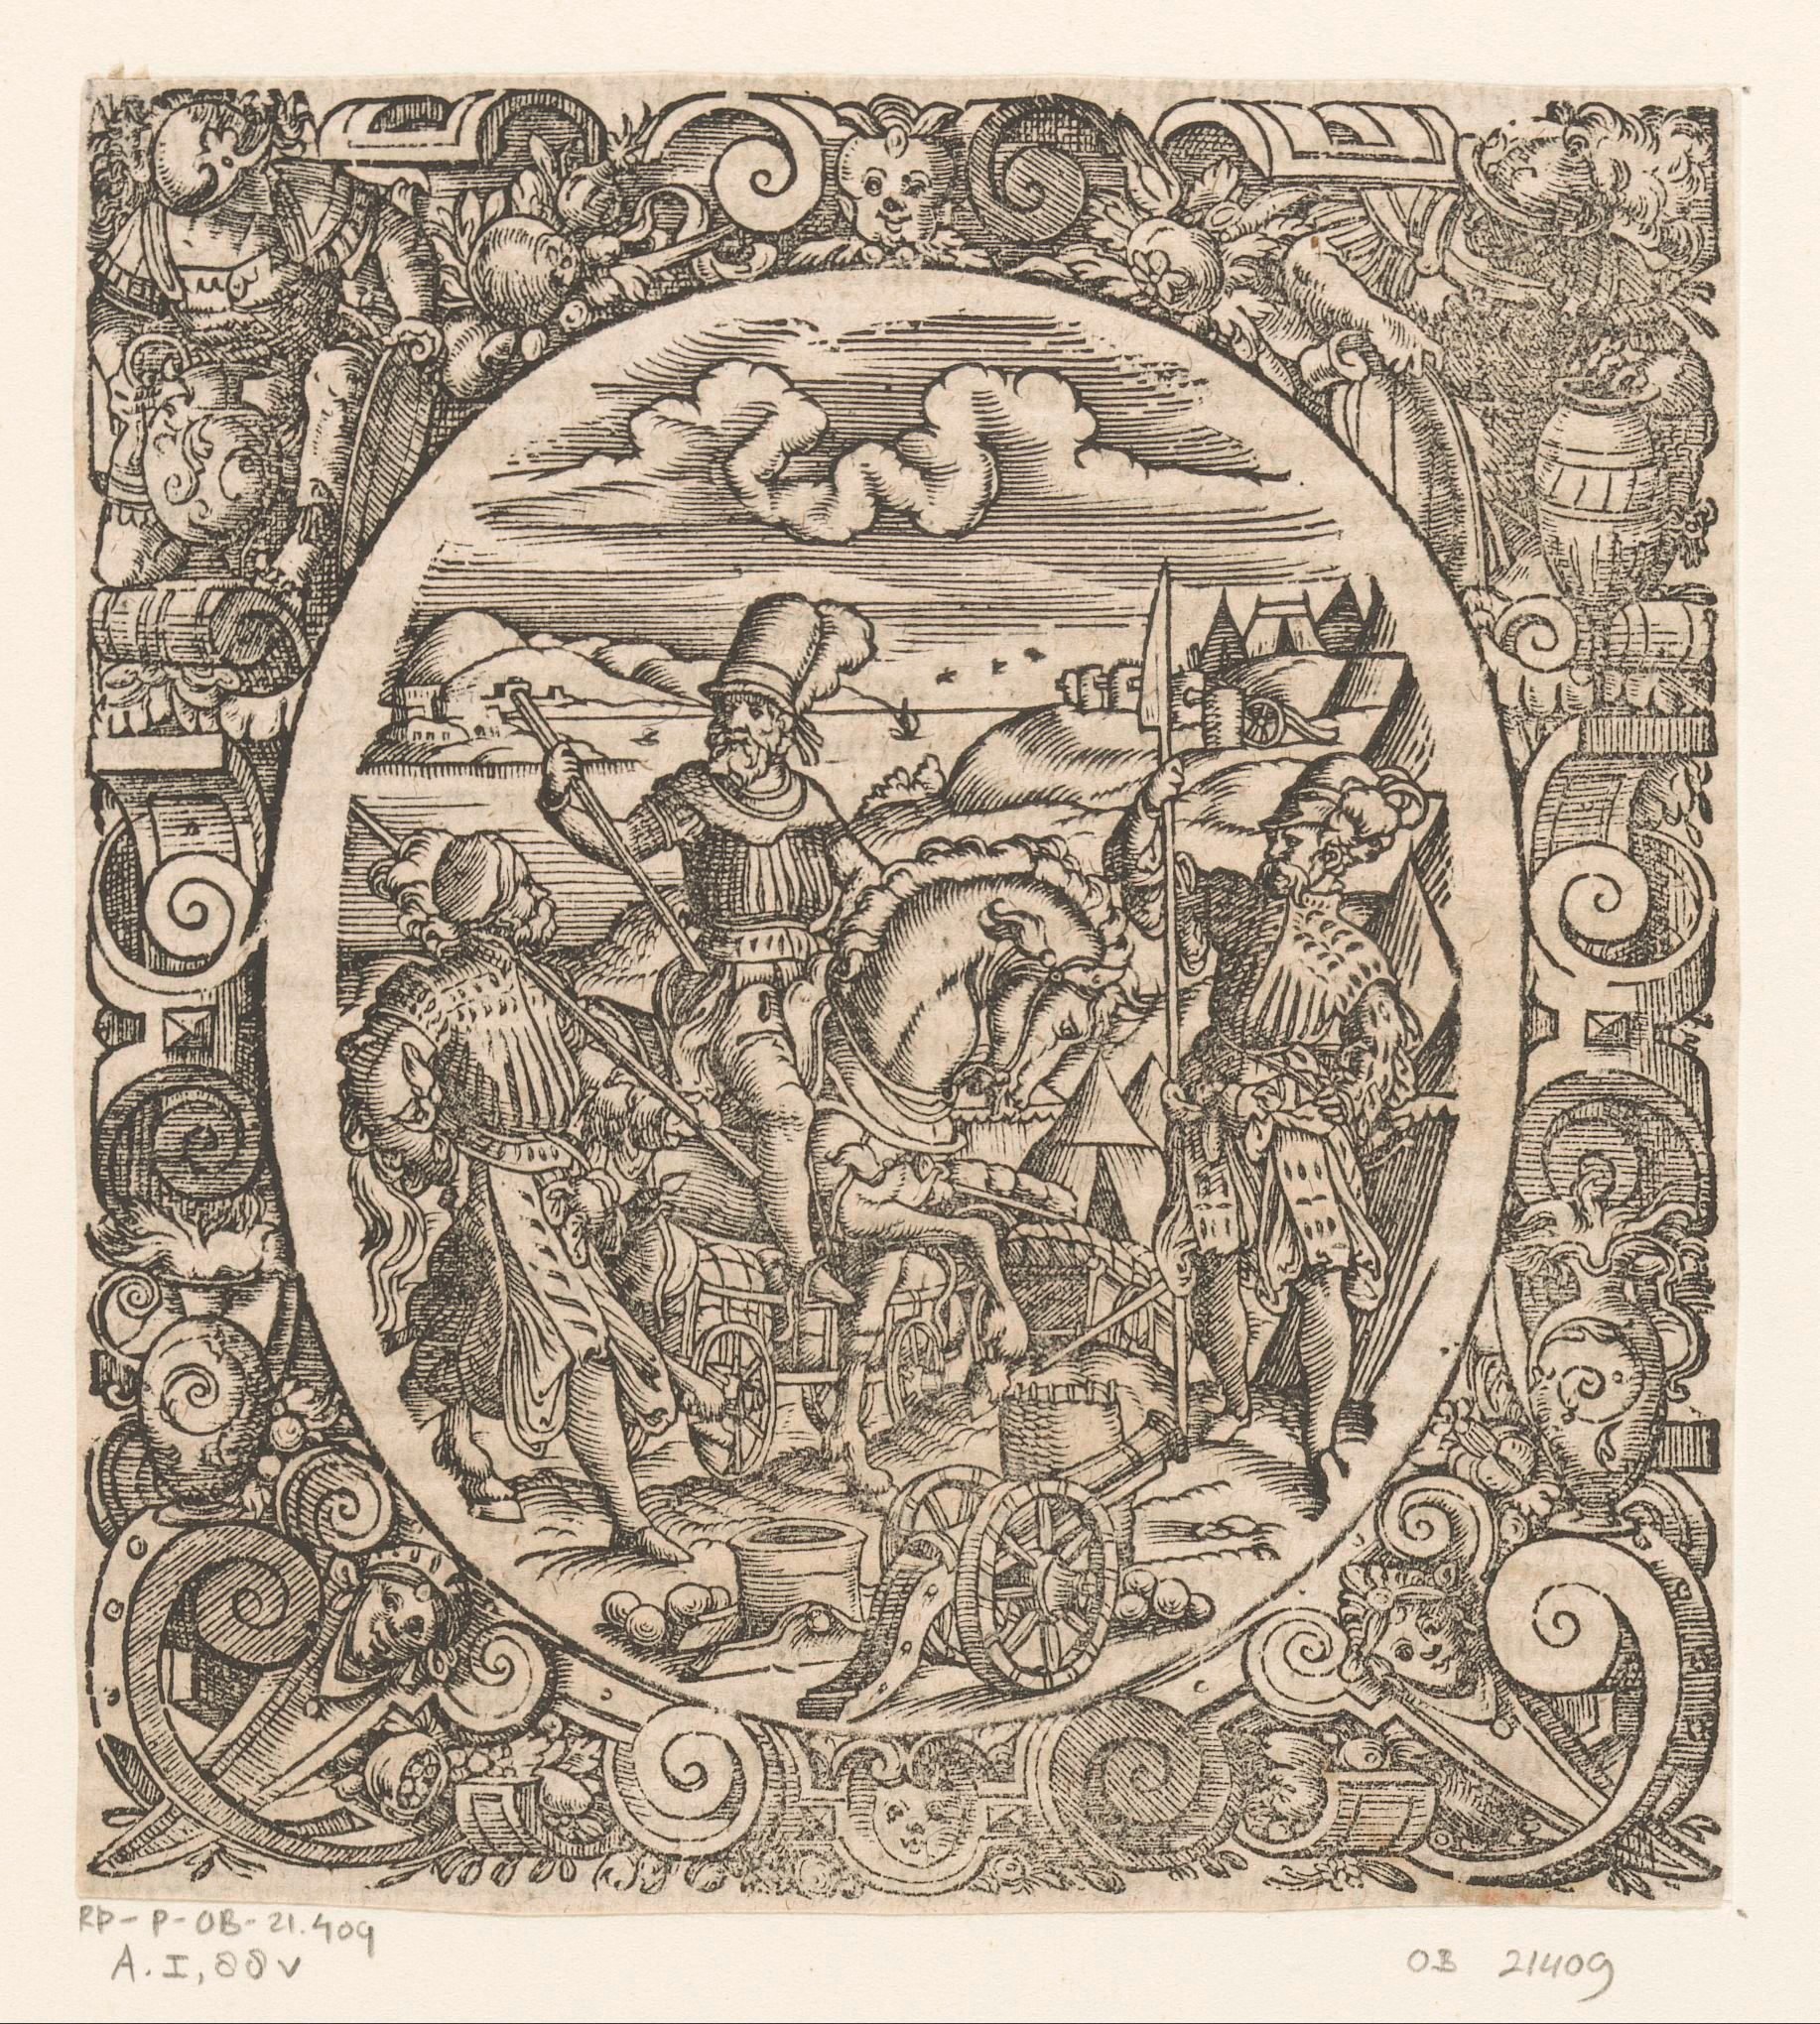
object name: print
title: Artillerieofficier met twee soldaten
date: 1573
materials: paper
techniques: woodcut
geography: frankfurt am main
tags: riding a horse, ass, or mule; rider, horseman, warfare; military affairs, the soldier; the soldier's life, officer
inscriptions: collector's mark: Lugt 240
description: Zowel de voorstelling als de ornamentrand werd gebruikt voor verschillende edities van Leonhardt Fronspergers Kriegsbuch.